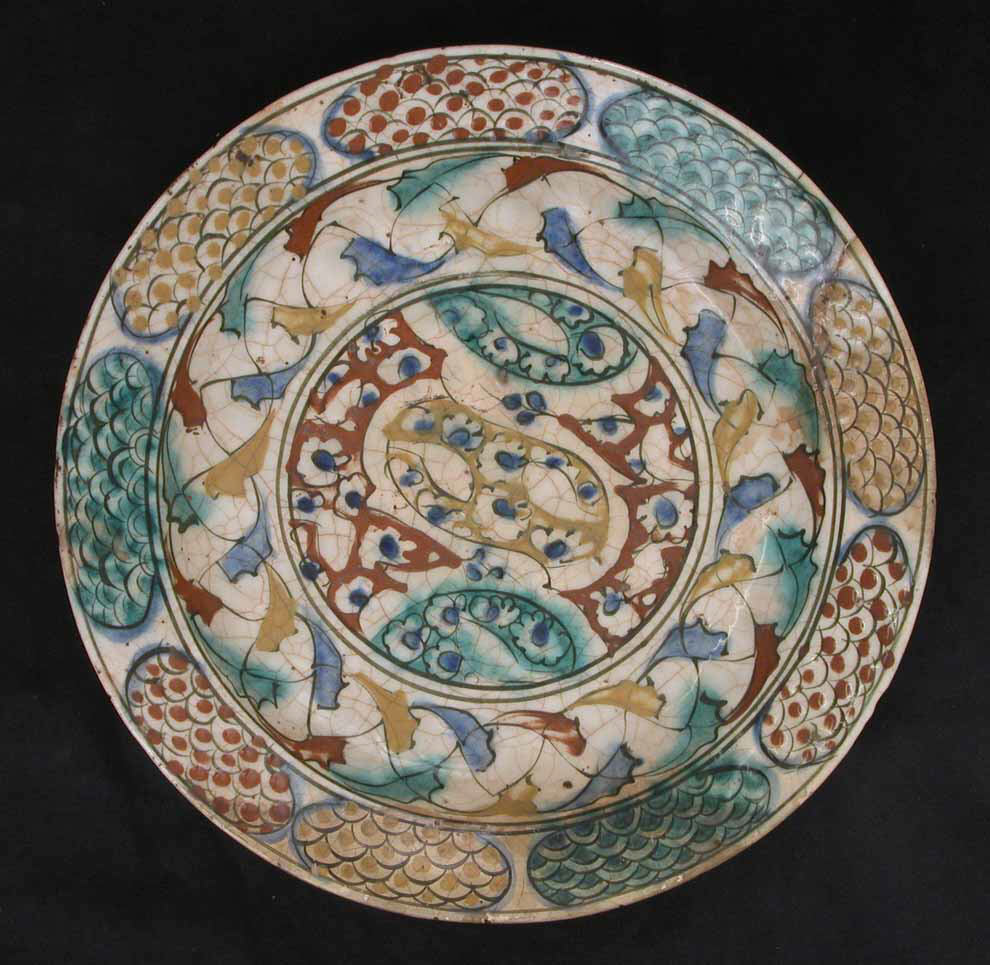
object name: dish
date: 1601-1700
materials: stonepaste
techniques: painting, underglaze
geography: iran